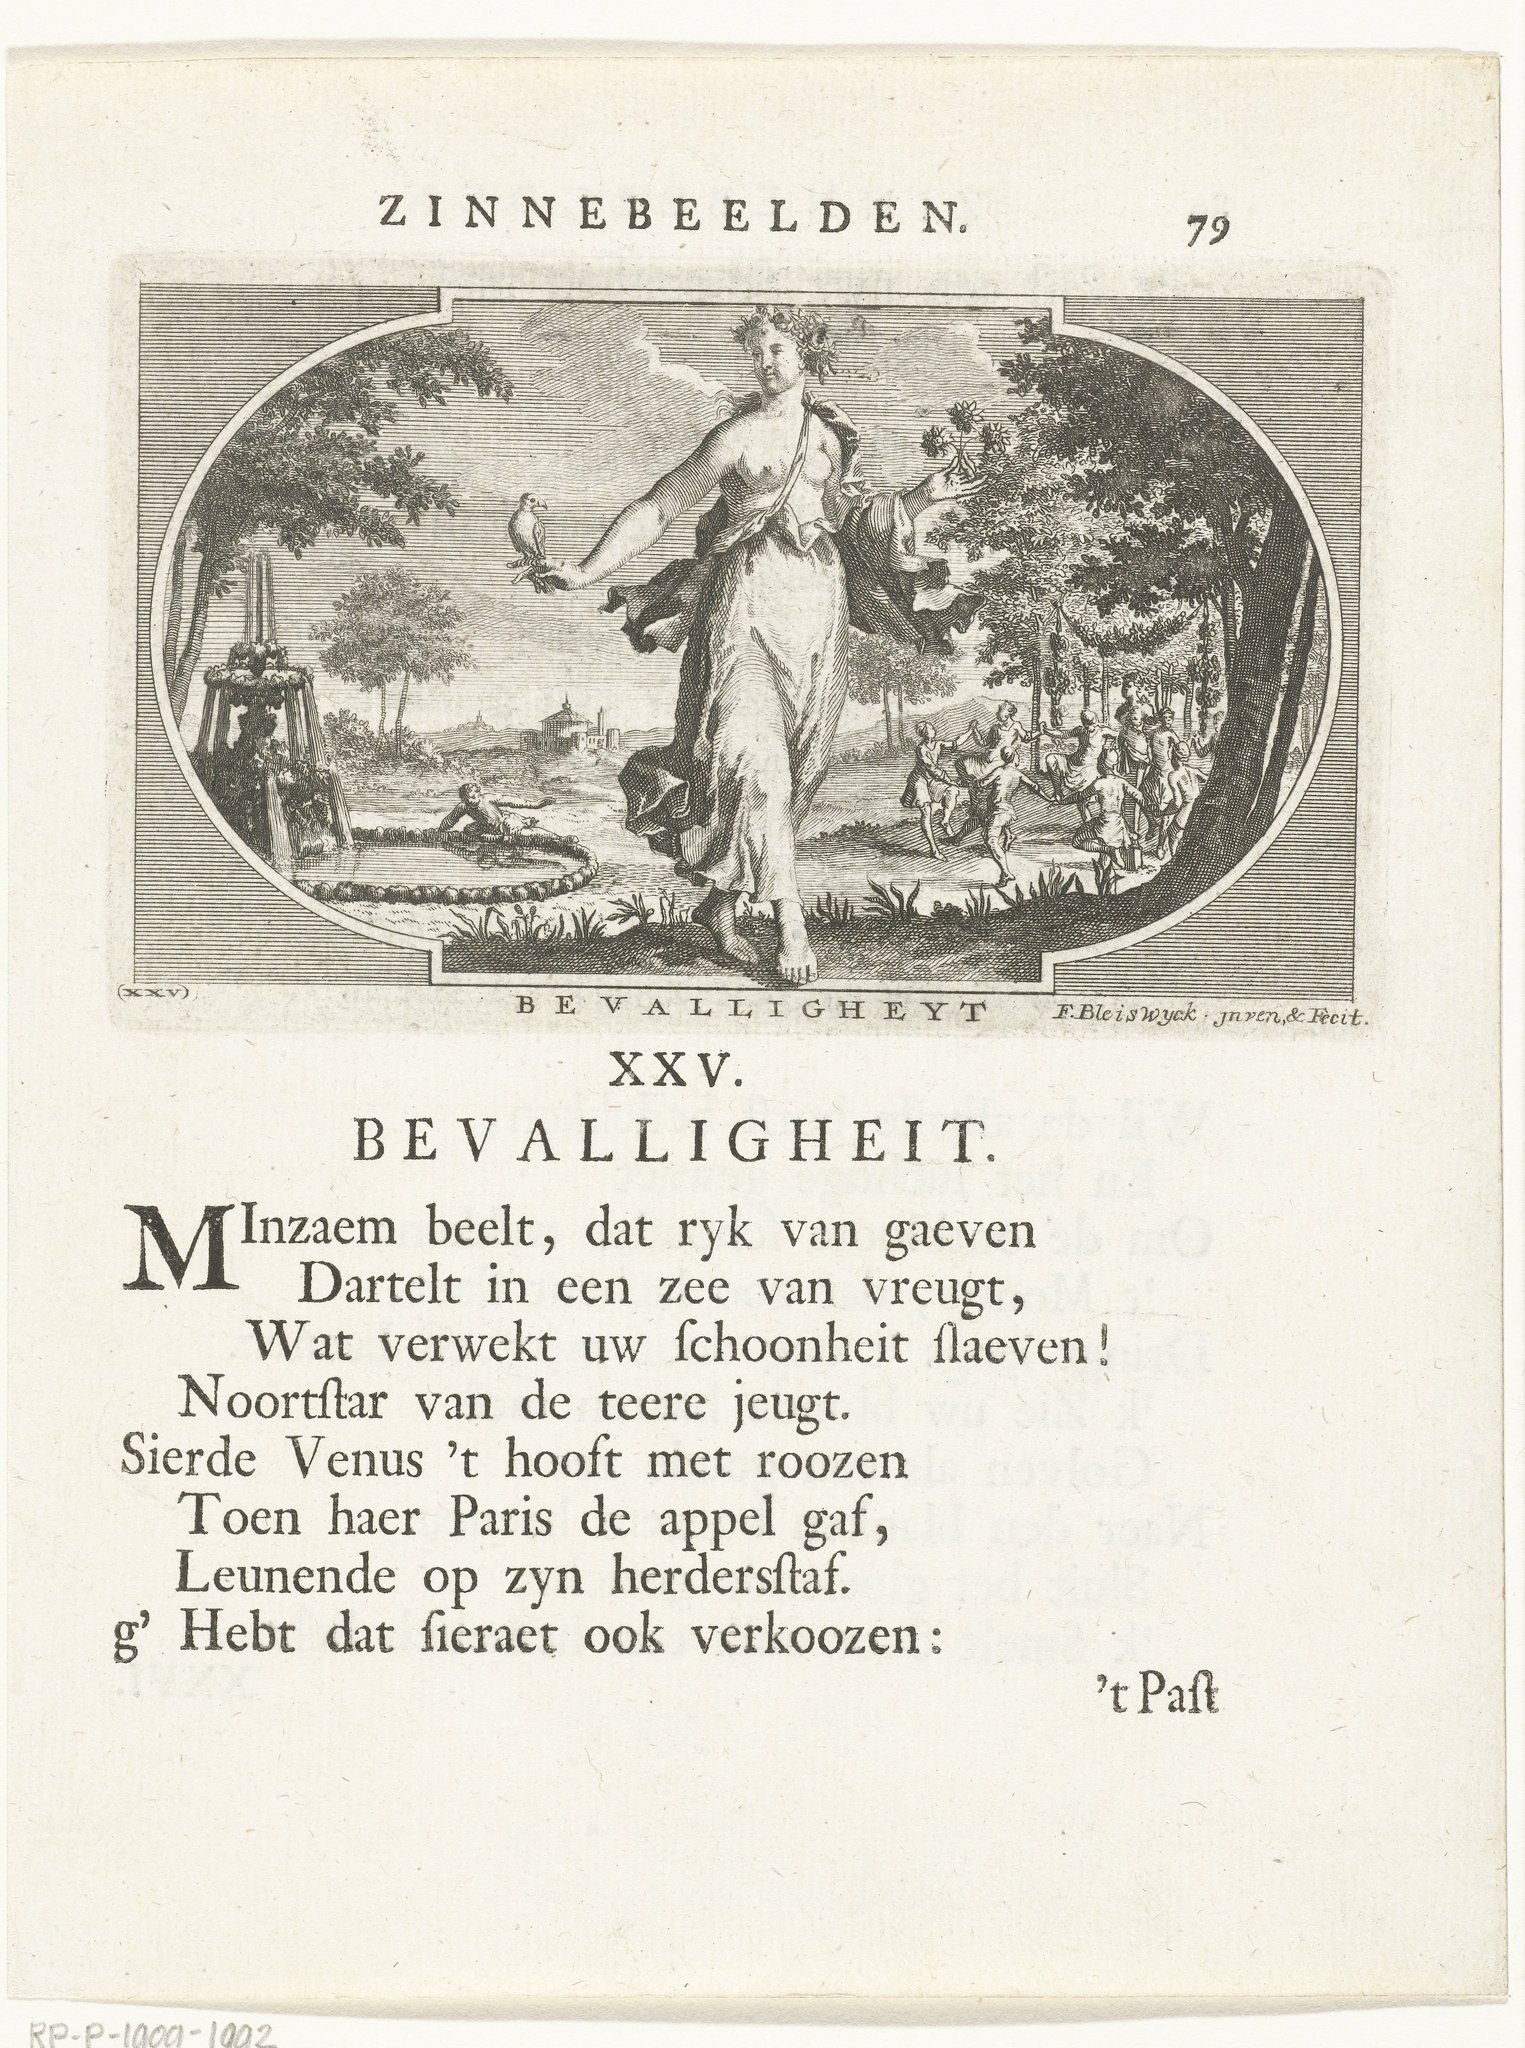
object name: book illustration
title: Bevalligheyt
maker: françois van bleyswijck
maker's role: draughtsman, print maker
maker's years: 1671-1746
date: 1681-1737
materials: paper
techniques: etching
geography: leiden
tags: grace, charm; 'gratia', 'venustà' (ripa)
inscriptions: collector's mark: Lugt 2228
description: Embleem met allegorie op bevalligheid verbeeld als vrouw met rozen en vogel in haar handen. In een landschap kijkt een man naar zijn spiegelbeeld in het wateroppervlak van een fontein en mannen dansten rond de buste van een vrouw. Onder de voorstelling en op het verso staat een gedicht over bevalligheid.